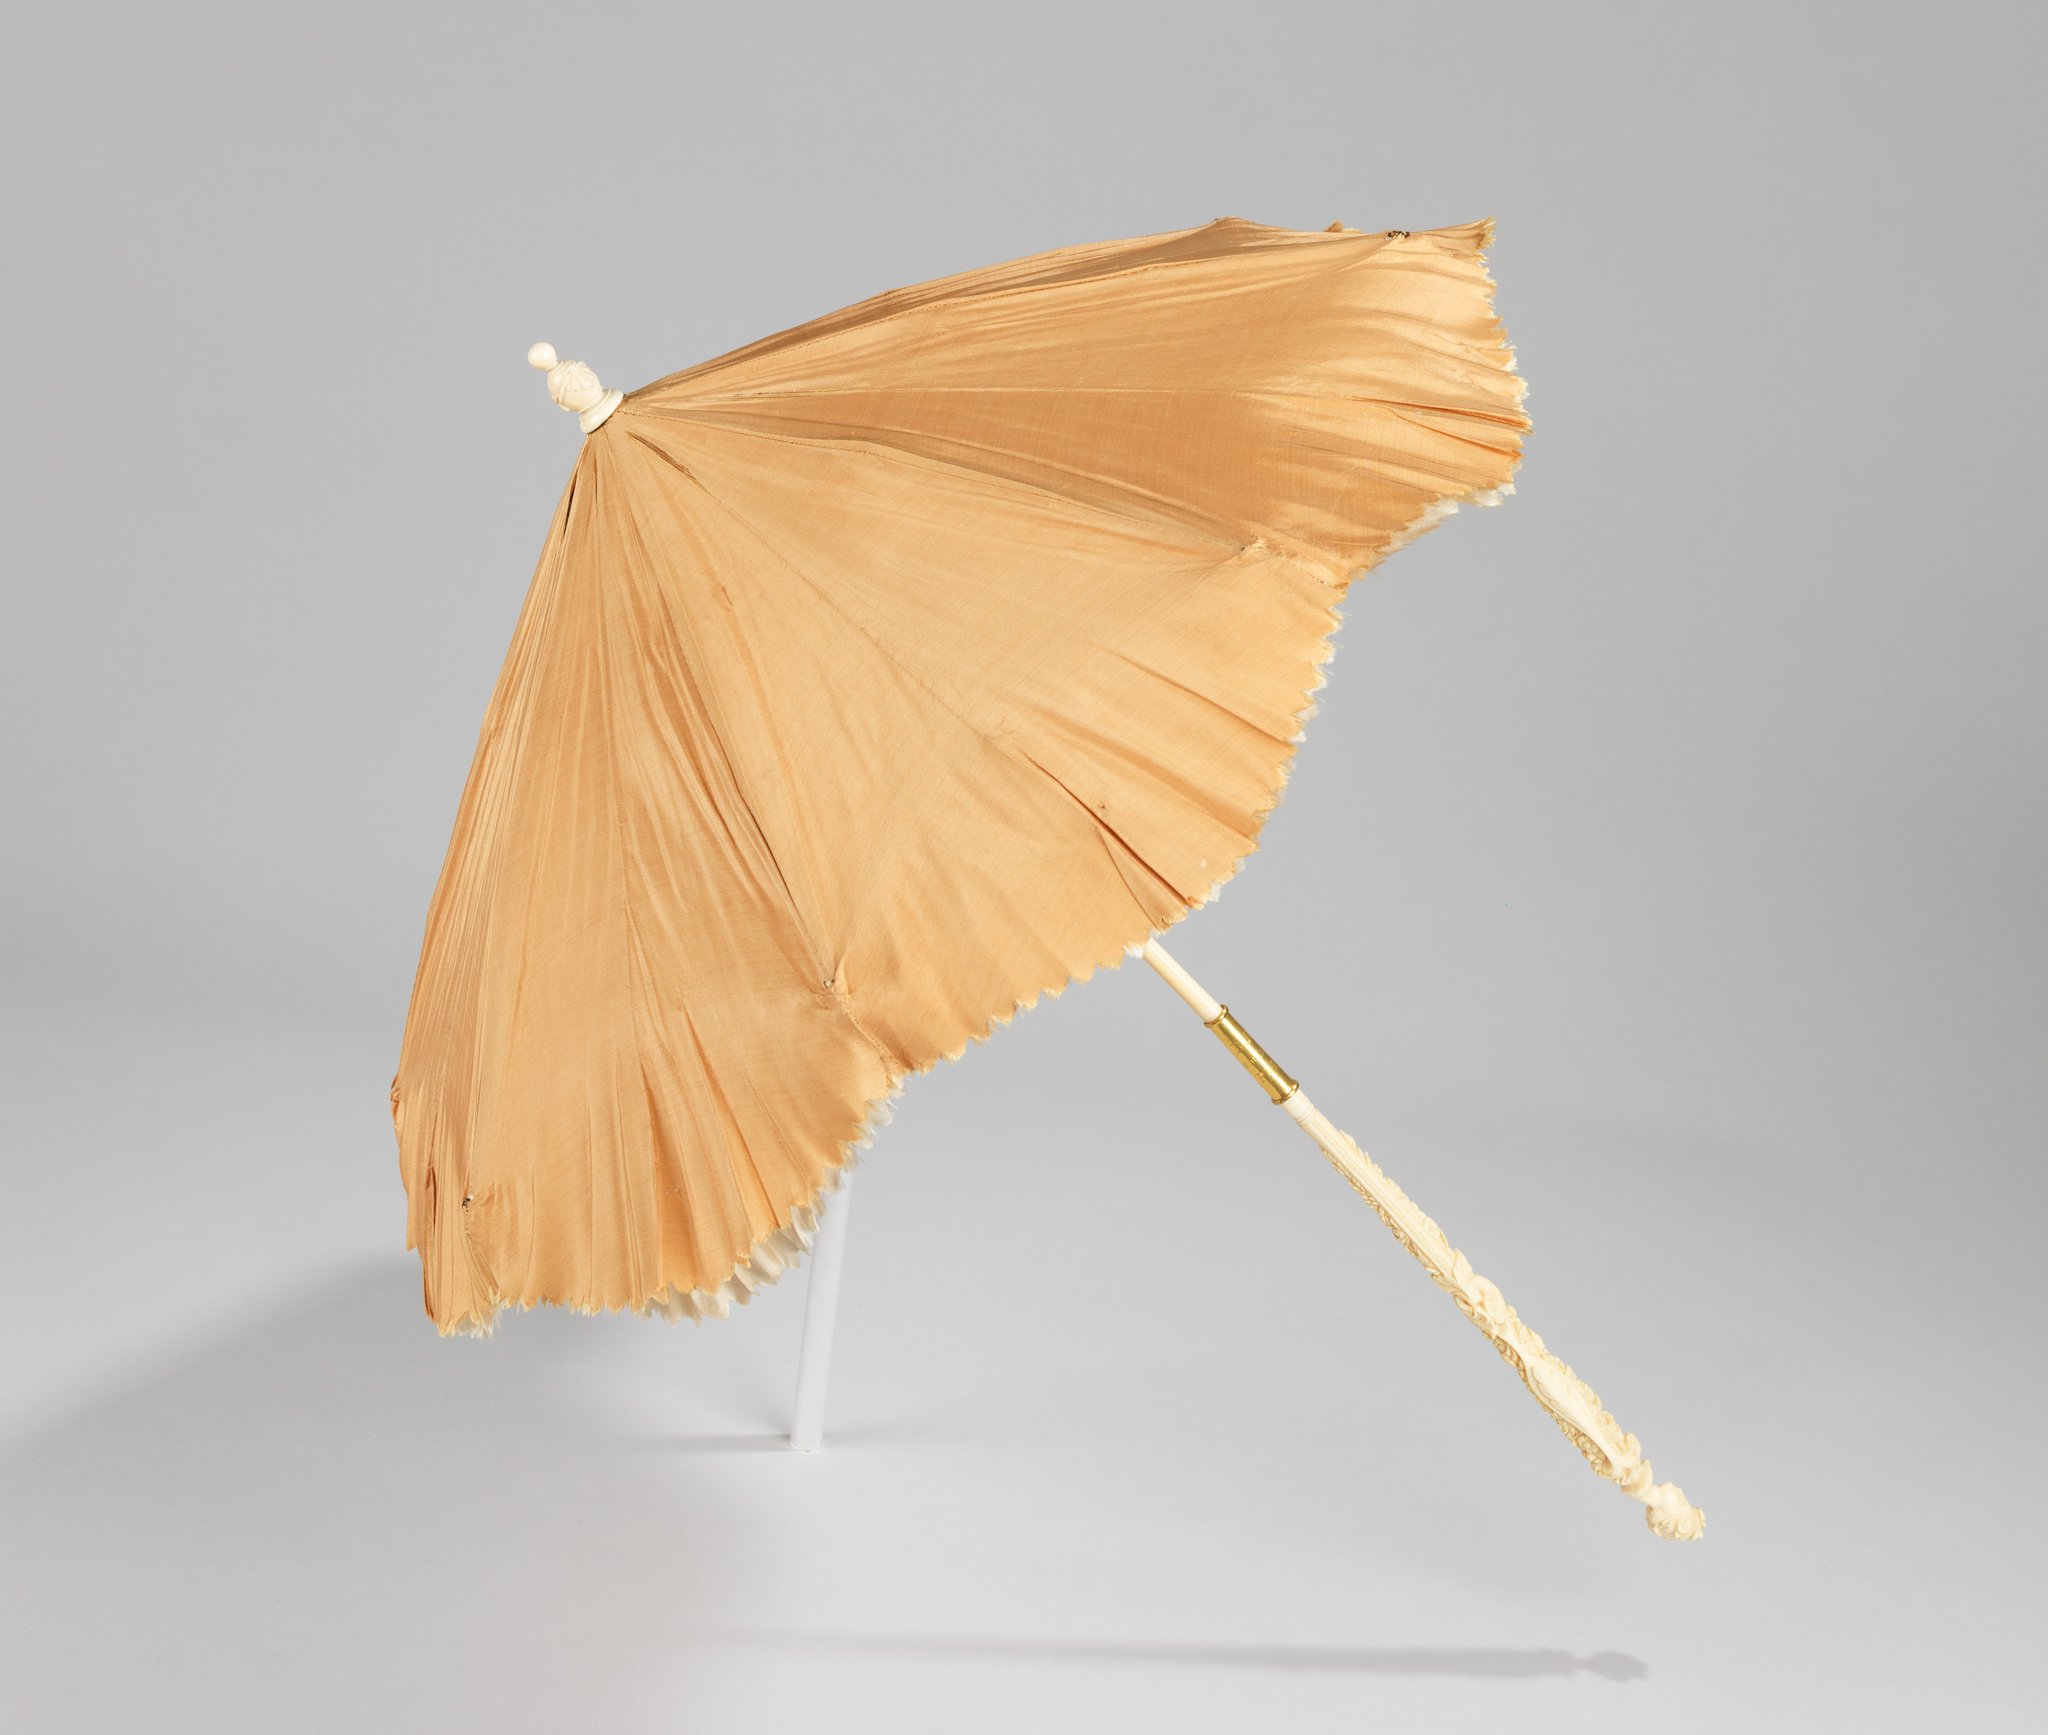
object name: parasol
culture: french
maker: dupuy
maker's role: designer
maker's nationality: french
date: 1868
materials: ivory, metal, silk